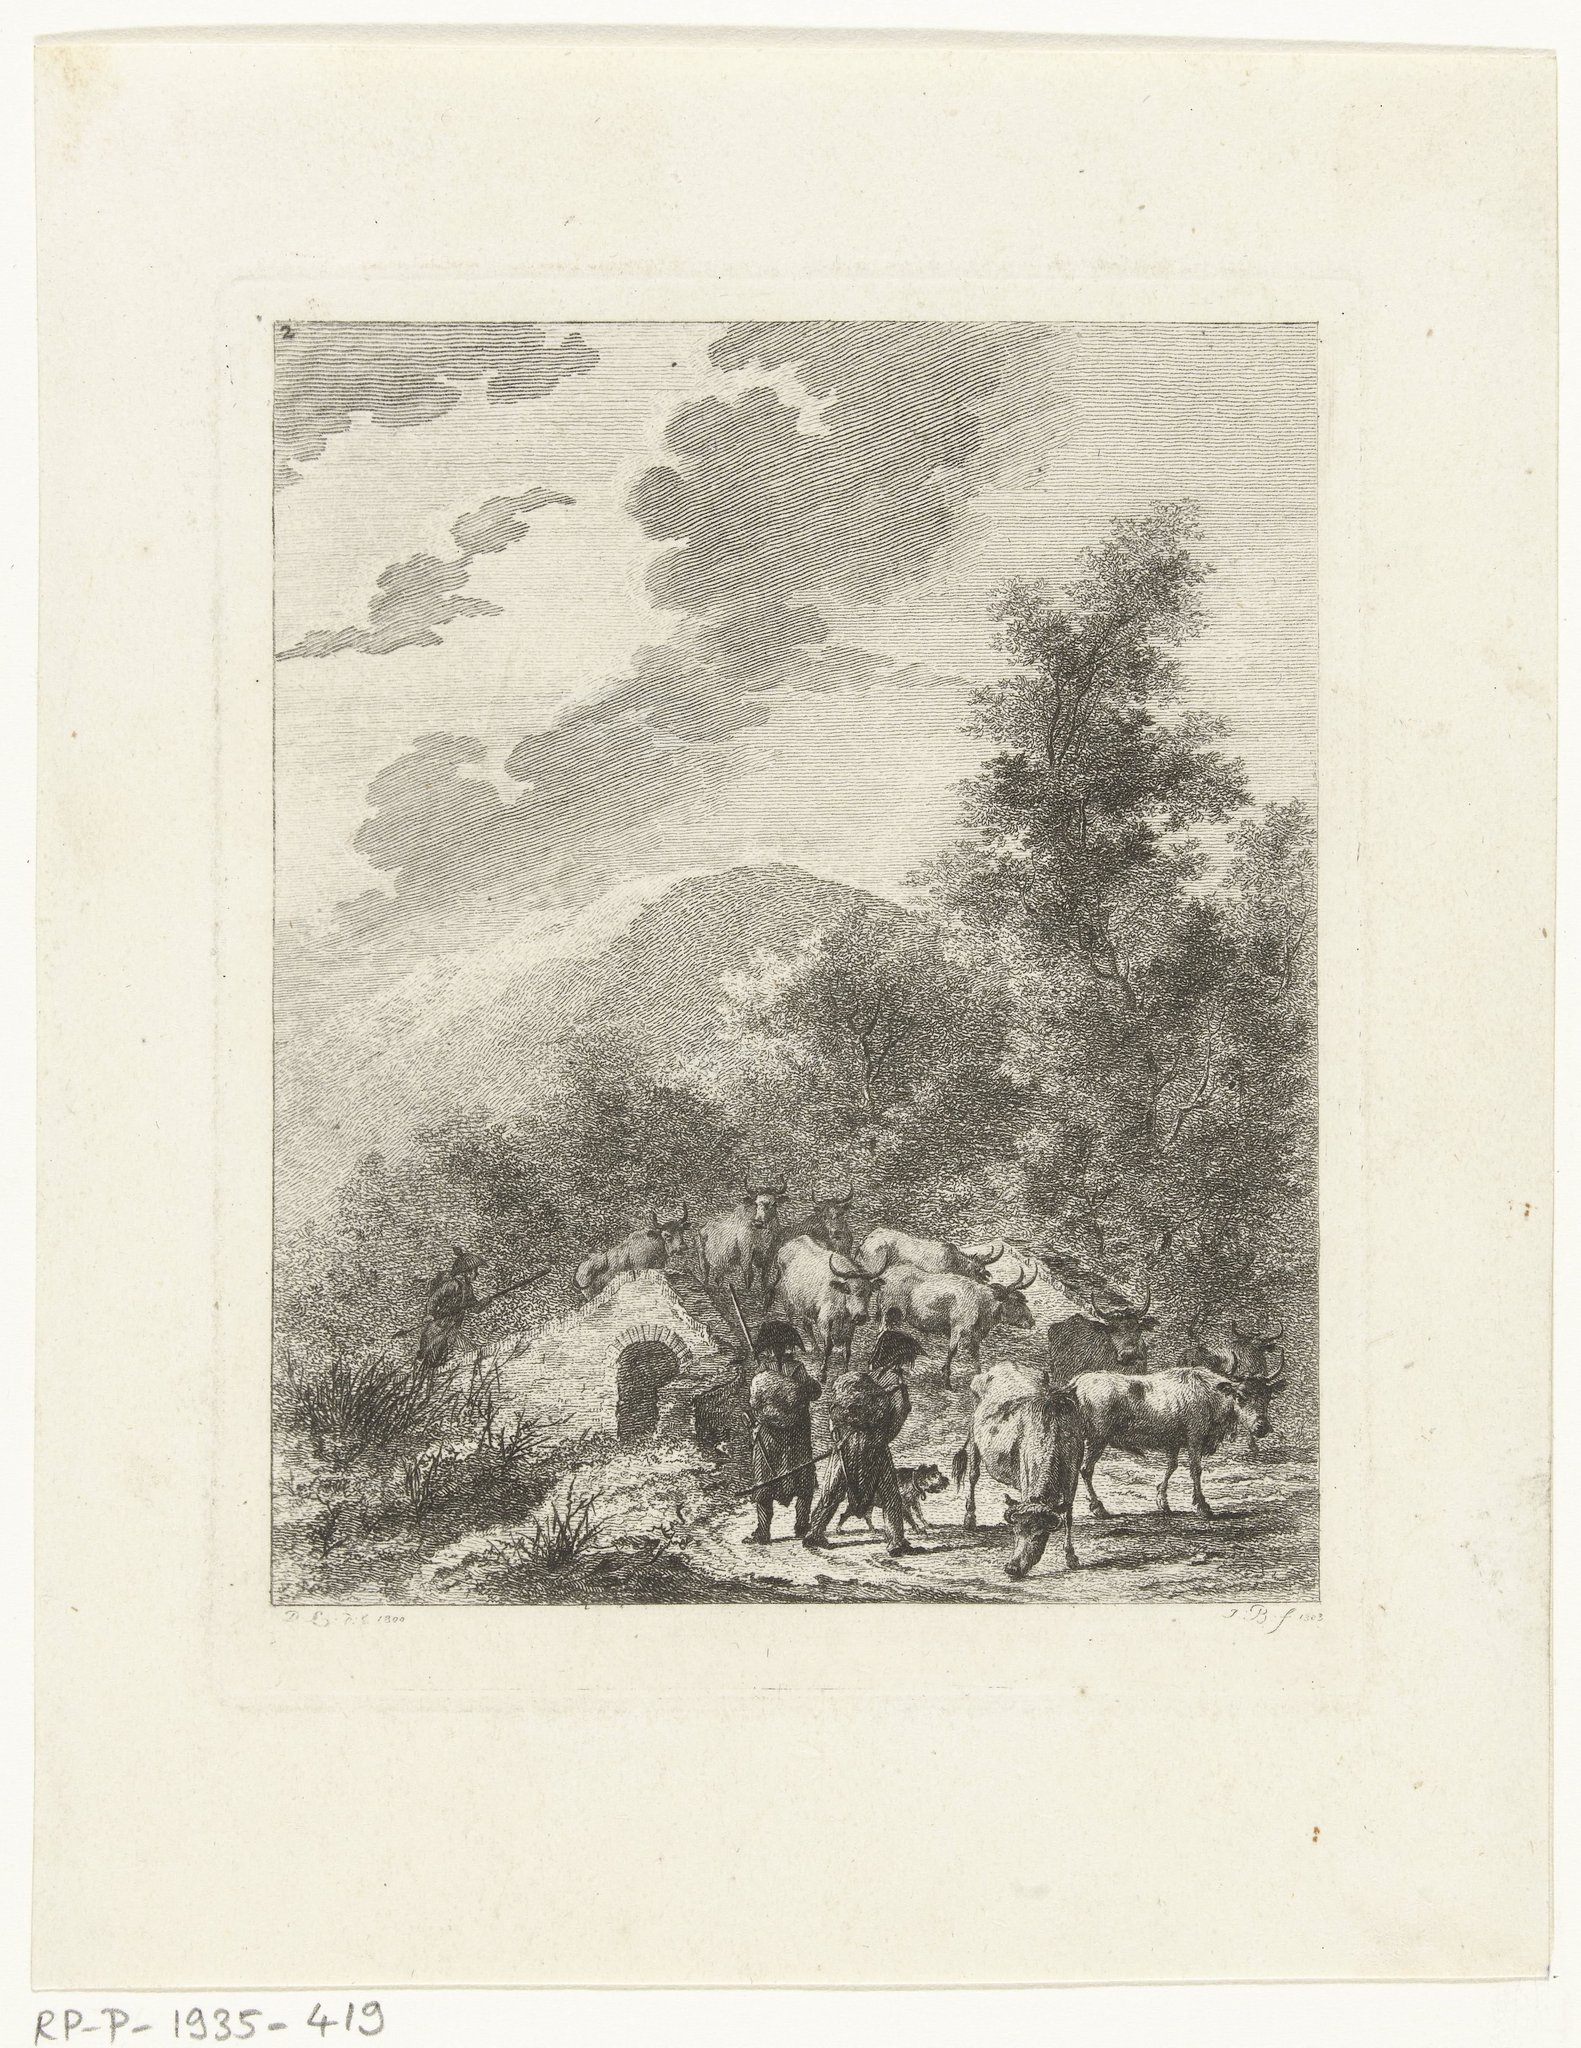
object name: print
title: Zes landschappen met soldatenstaffage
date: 1803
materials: paper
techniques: etching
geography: rotterdam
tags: the soldier; the soldier's life, herd, flock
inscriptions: collector's mark: Lugt 2228, collector's mark: Lugt 1377, collector's mark: Lugt 2760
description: Landschap met drie Napoleontische soldaten die een kudde koeien over een brug drijven.